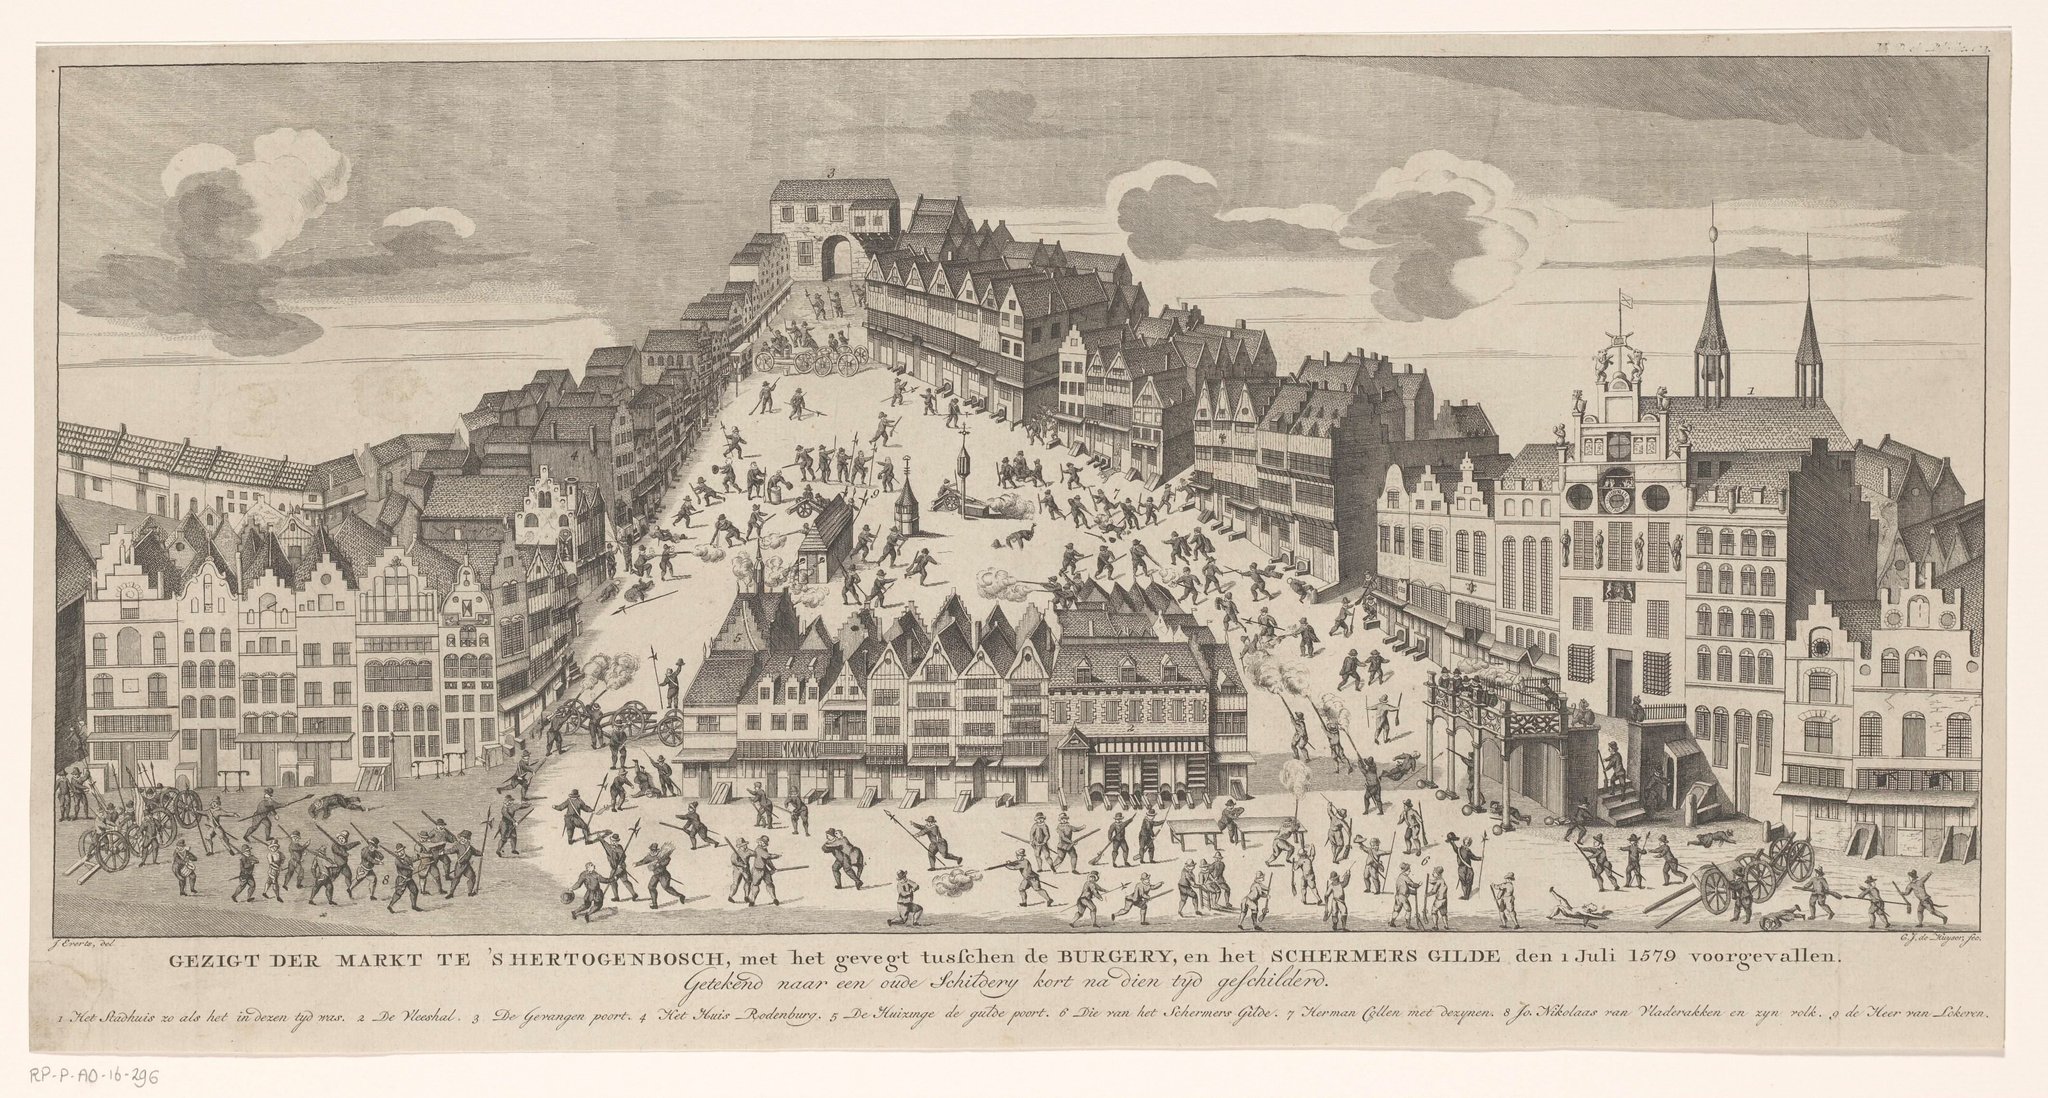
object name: print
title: Gezigt der markt te 's Hertogenbosch, met het gevegt tusschen de Burgery, en het Schermers Gilde den 1 Juli 1579 voorgevallen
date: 1776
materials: paper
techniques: engraving, etching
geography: northern netherlands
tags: street-fights, riots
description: Prent ook gebruikt in: Heurn, Johan Hendrik van. Historie der stad en Meyerye van 's Hertogenbosch, alsmede van de voornaamste daaden der hertogen van Brabant. 4 delen. Utrecht: Johannes van Schoonhoven & Co., 1776-1778, dl. 2 (1776), p. 121. Het schilderij van Diepenbeeck bevindt zich in de collectie van het Noordbrabants Museum (inv.nr. 00852).